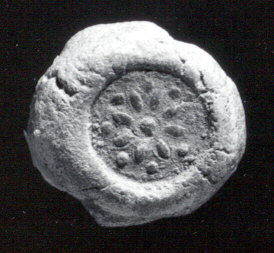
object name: sealing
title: Sealing with stamp seal impression: rosette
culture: assyrian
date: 1800-1701 BCE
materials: ceramic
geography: anatolia